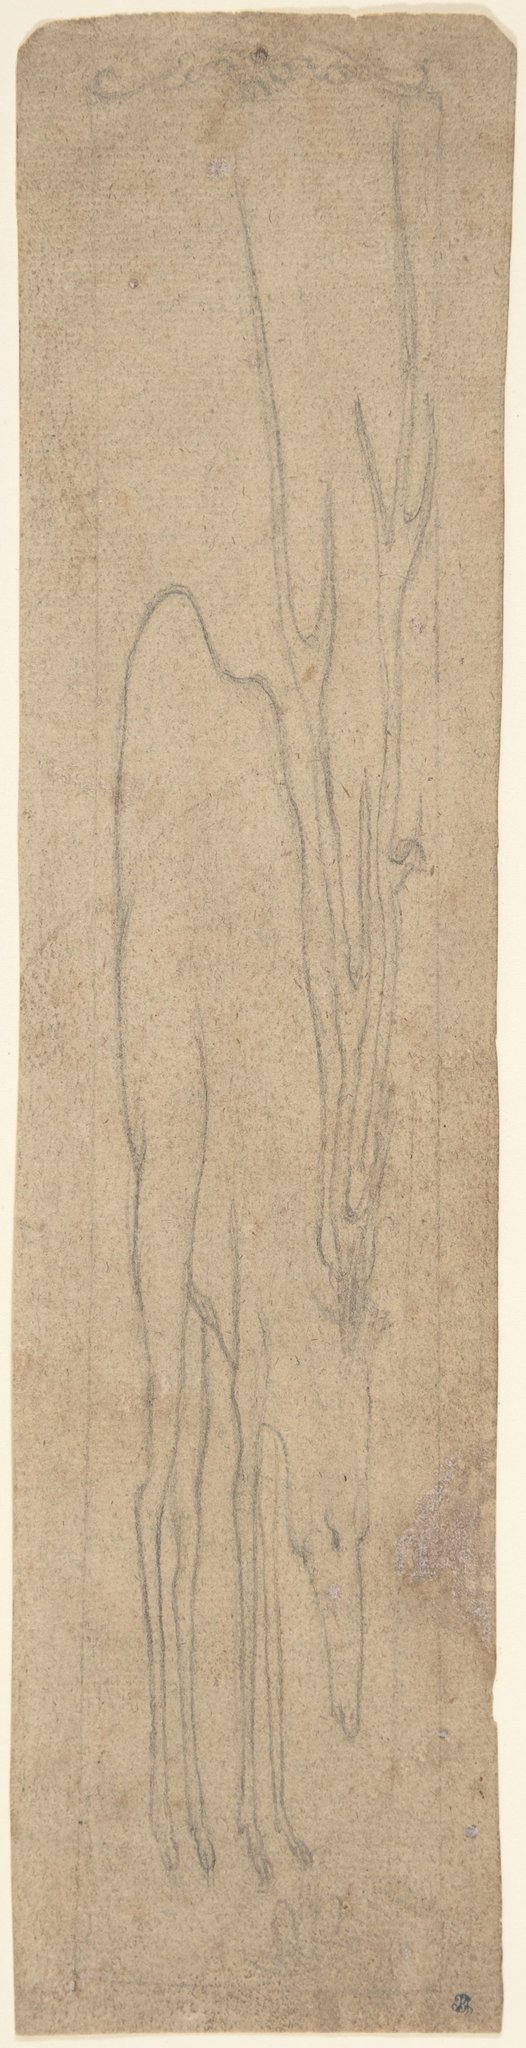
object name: drawing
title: Anamorphic Drawing of a Stag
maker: anonymous, german, 16th century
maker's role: artist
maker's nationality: german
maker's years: 1500-1600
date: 1501-1600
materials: chalk, paper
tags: deer